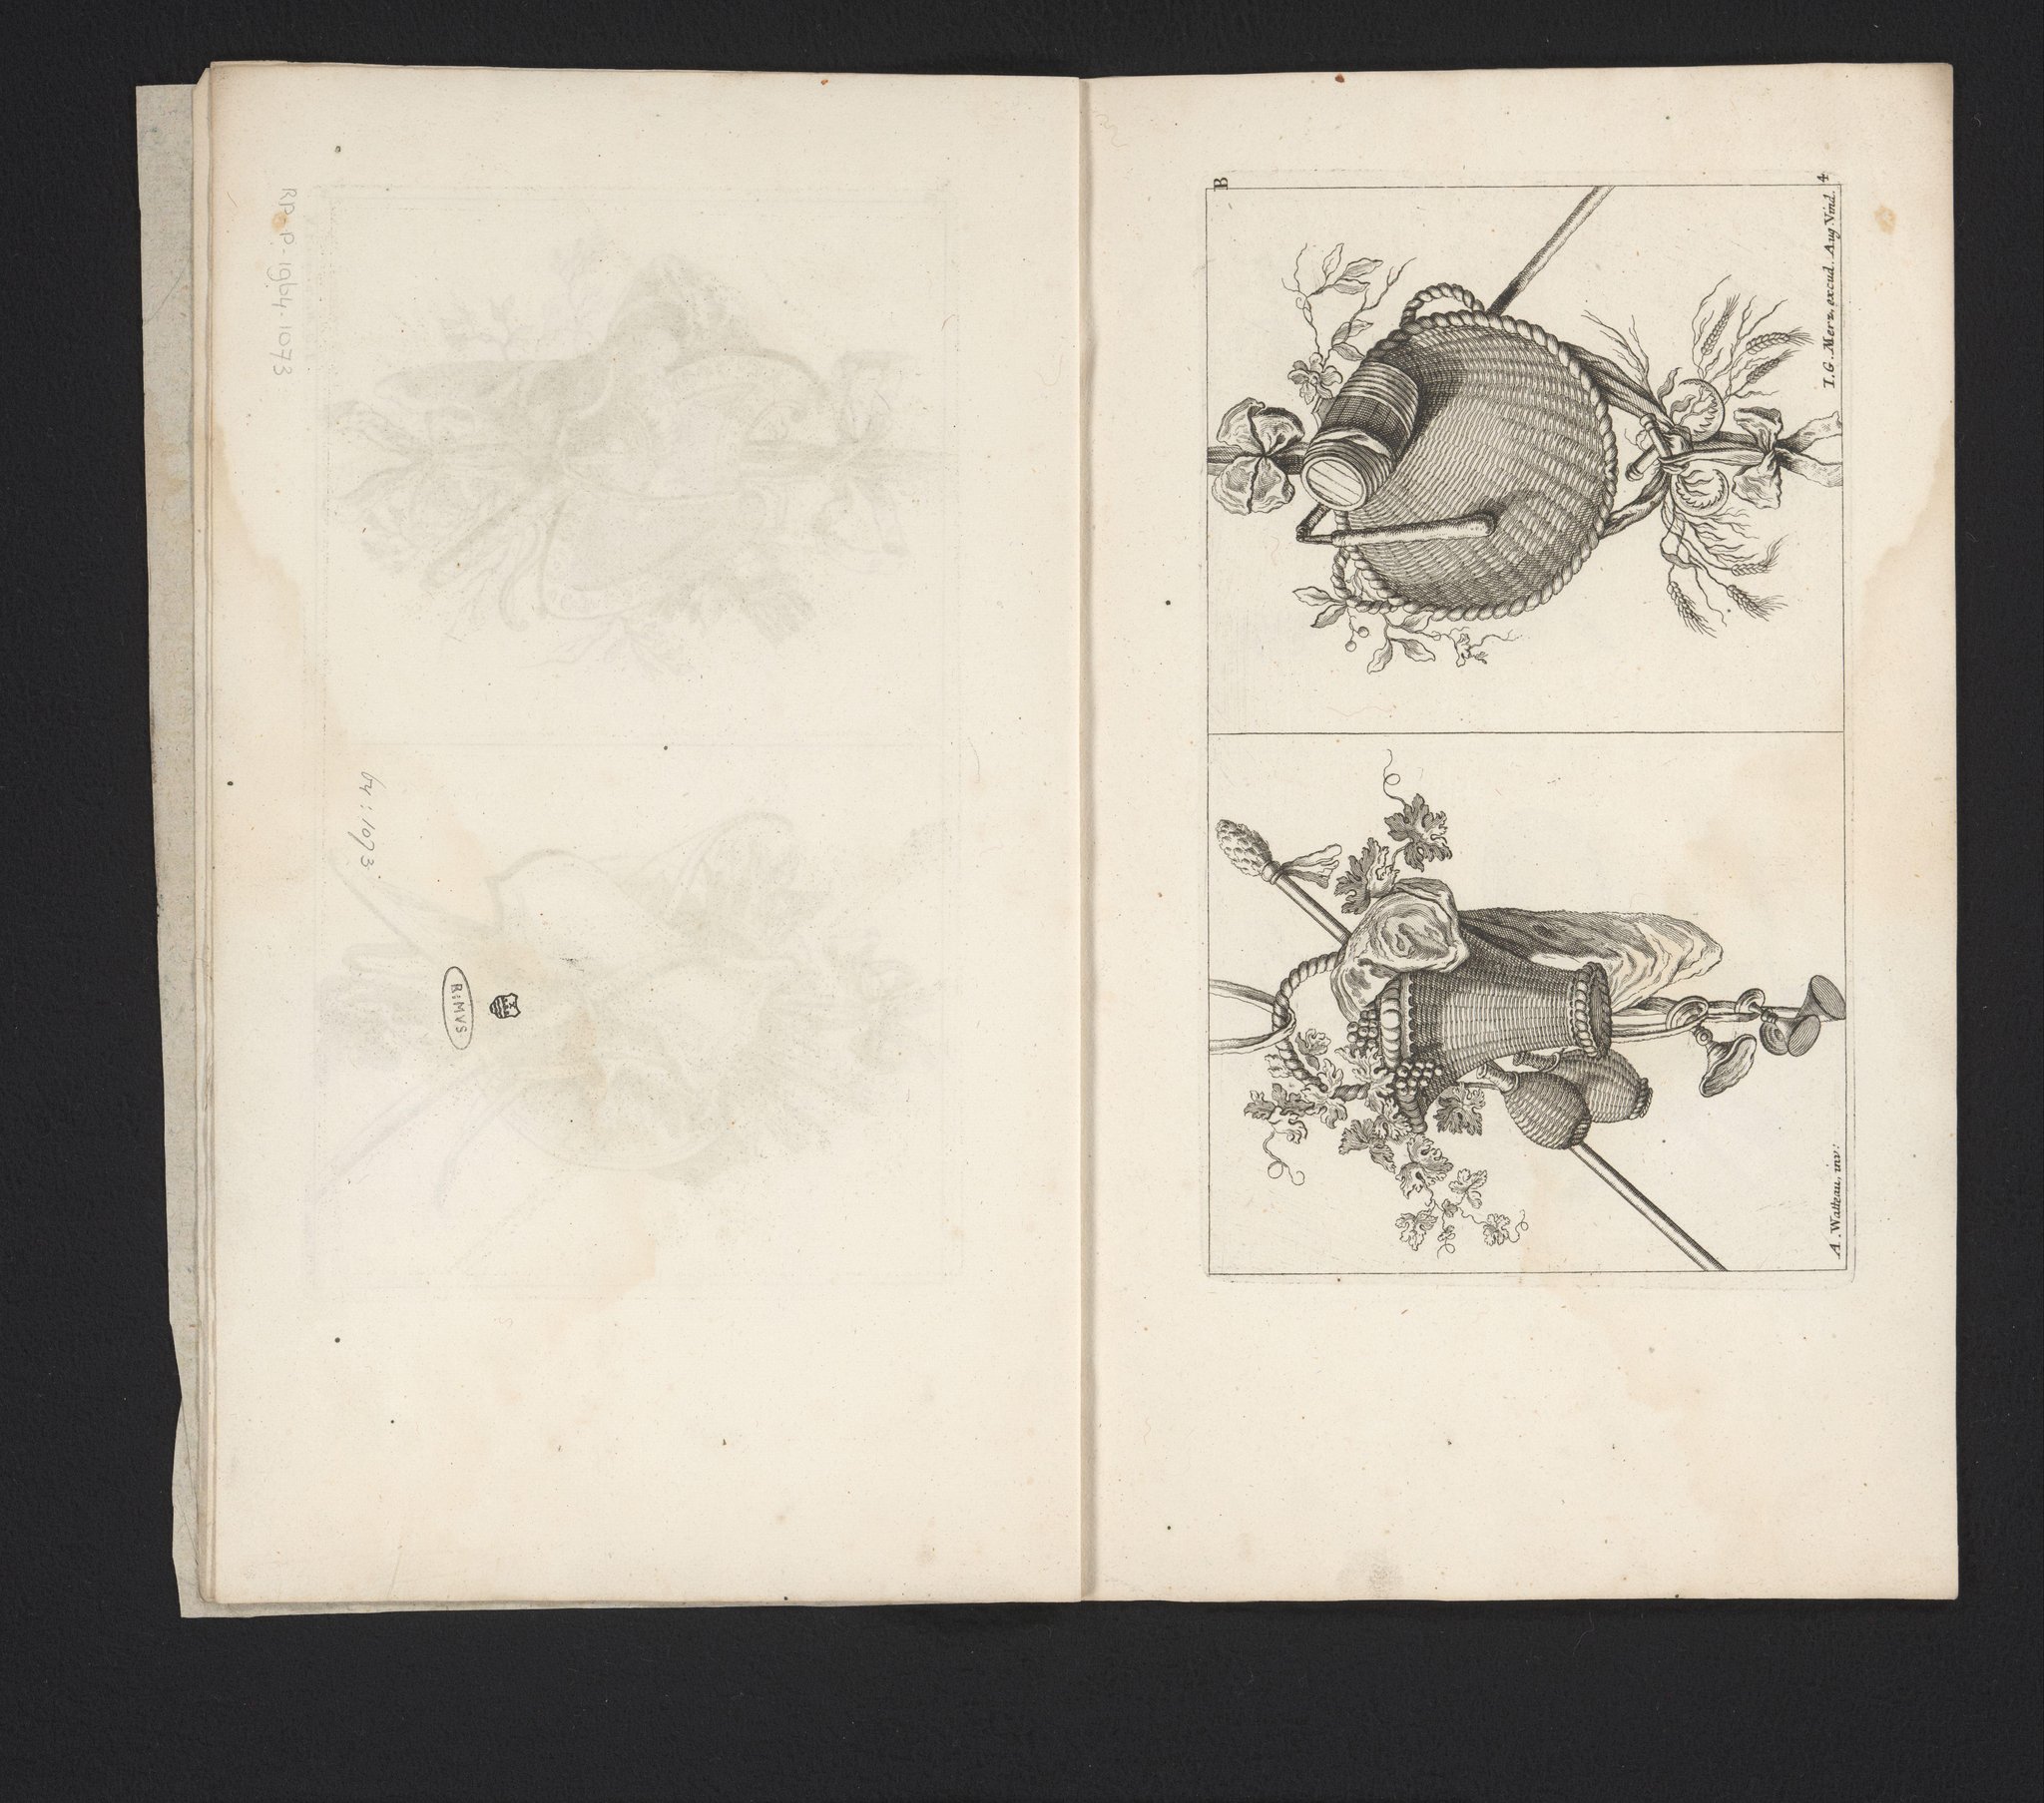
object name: album leaf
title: Trofeeën met manden, thyrsus en dorsvlegel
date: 1704-1762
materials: paper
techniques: etching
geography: augsburg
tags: thyrsus ~ attribute of bacchus, trophy, i.e.: decorative arrangement of symbolic or typical objects ~ ornament, agricultural implements: flail, container made of plant material other than wood: basket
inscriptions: collector's mark: Lugt 2760, collector's mark: Lugt 2228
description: Links een trofee met een mand, een thyrsus, druivenranken, twee flessen en drinkbekers. Rechts een trofee met een mand, korenaren, sikkels, een ton en een dorsvlegel. Rechts boven B genummerd. Prent maakt deel uit van een album met een serie van zes trofeeën.